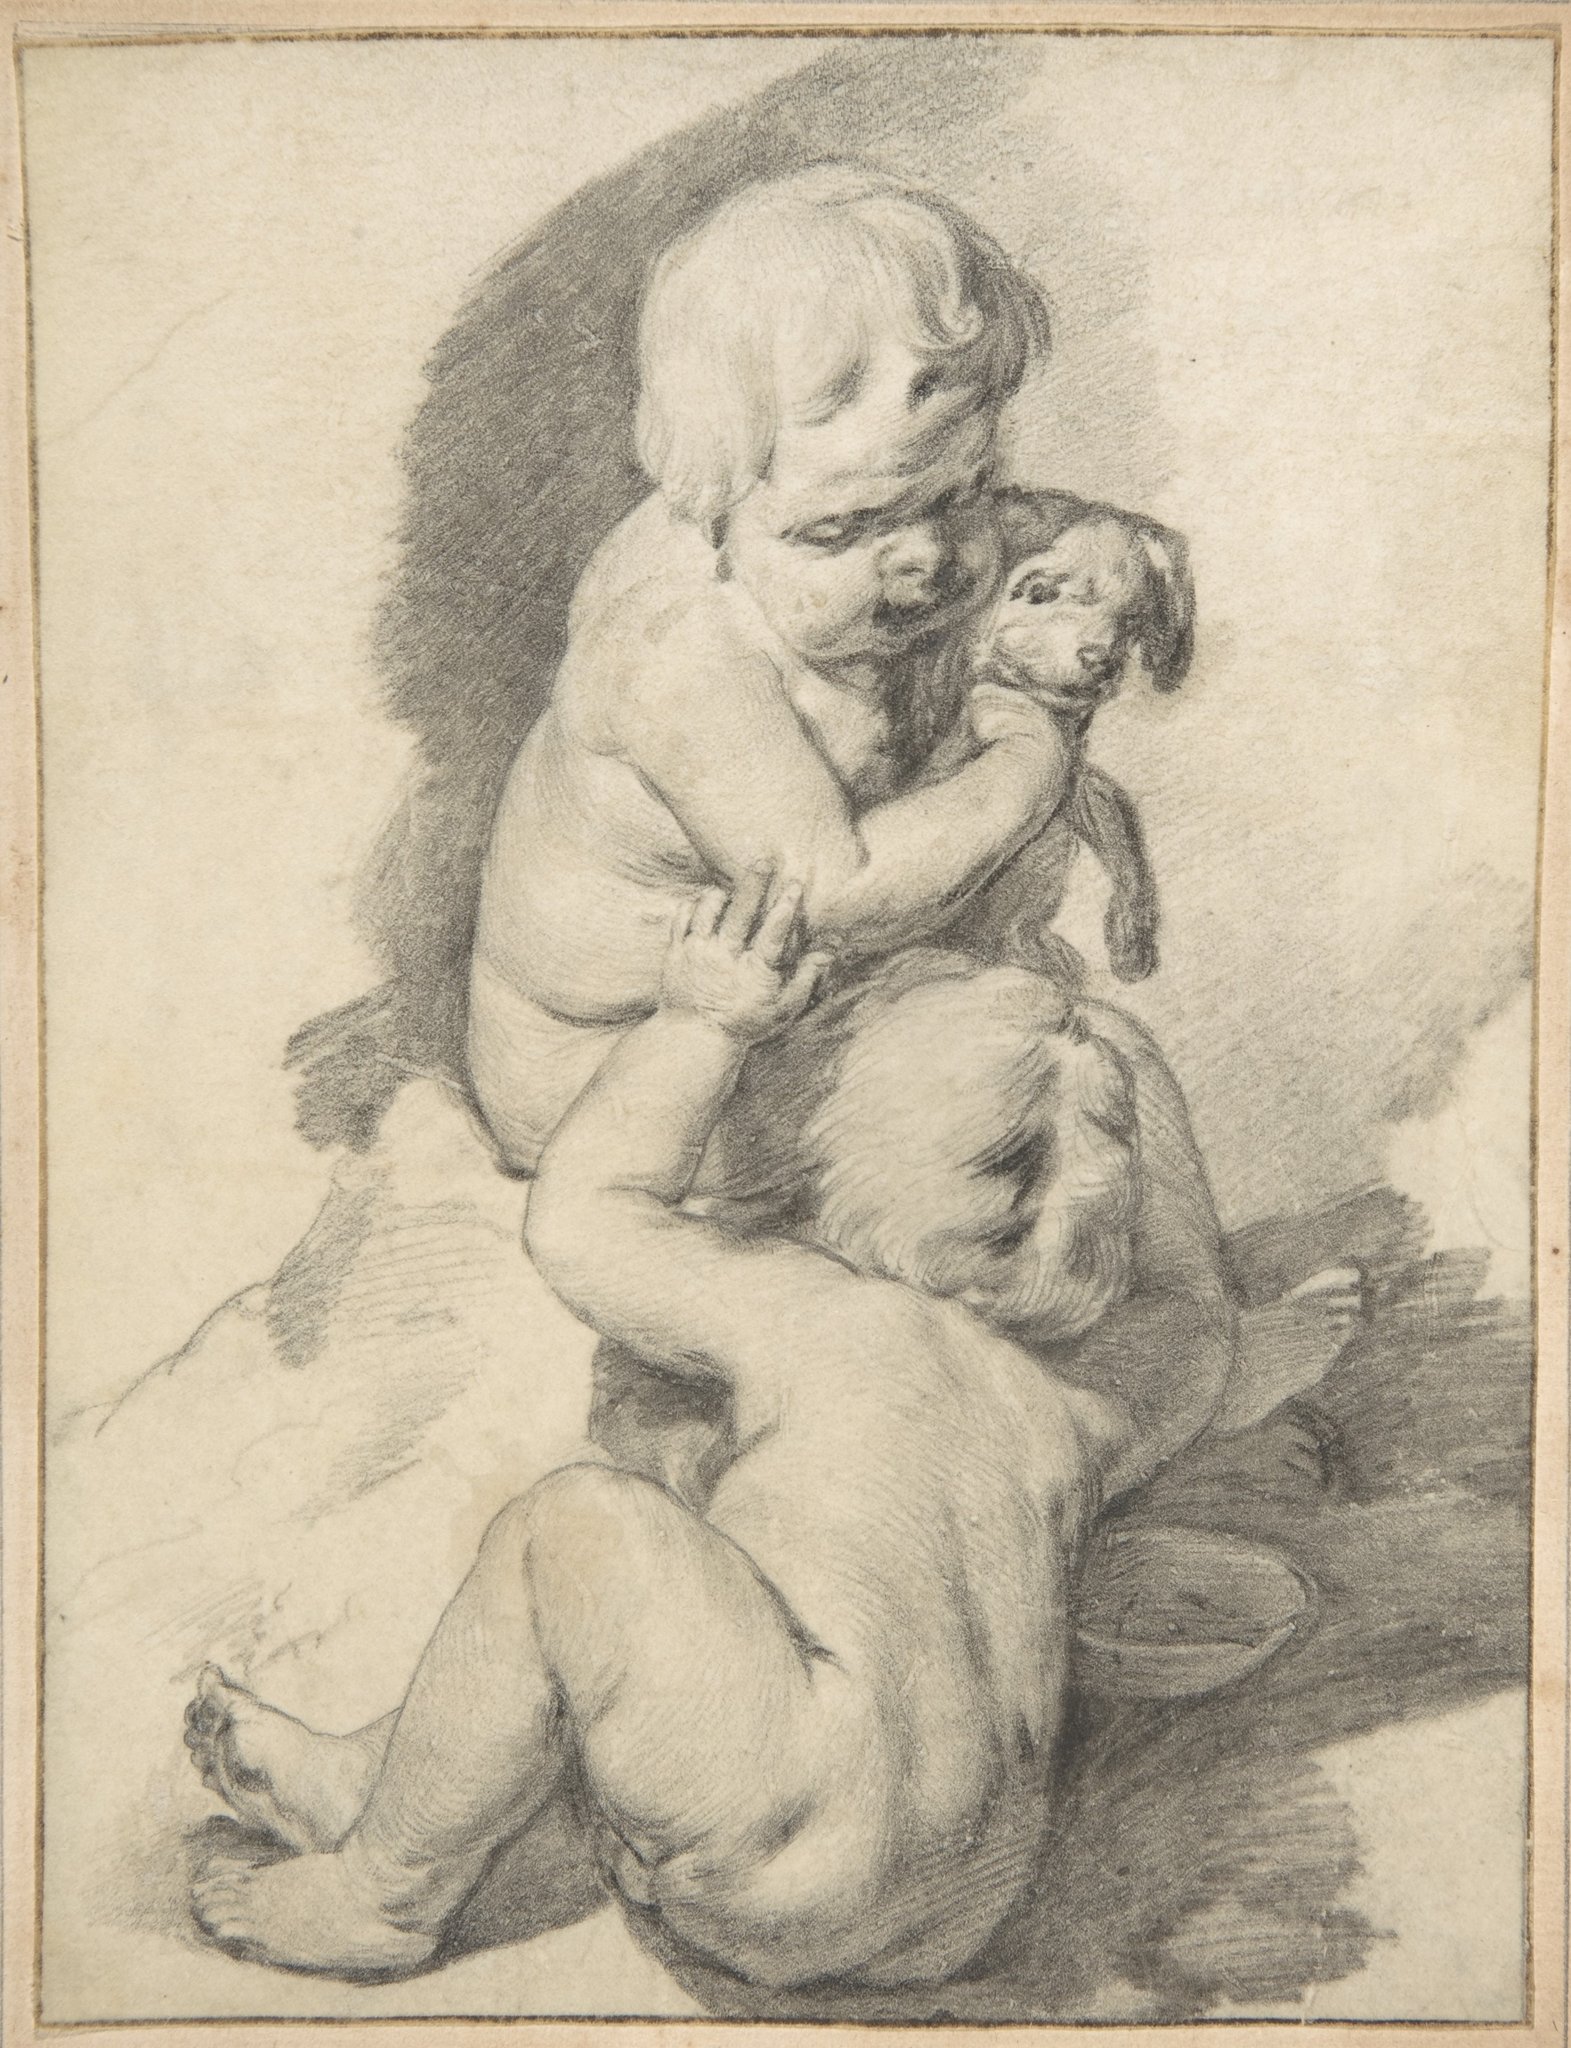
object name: drawing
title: Two Boys with a Puppy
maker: cornelis visscher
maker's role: artist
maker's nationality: dutch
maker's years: 1628-1658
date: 1656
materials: chalk, graphite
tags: boys,dogs